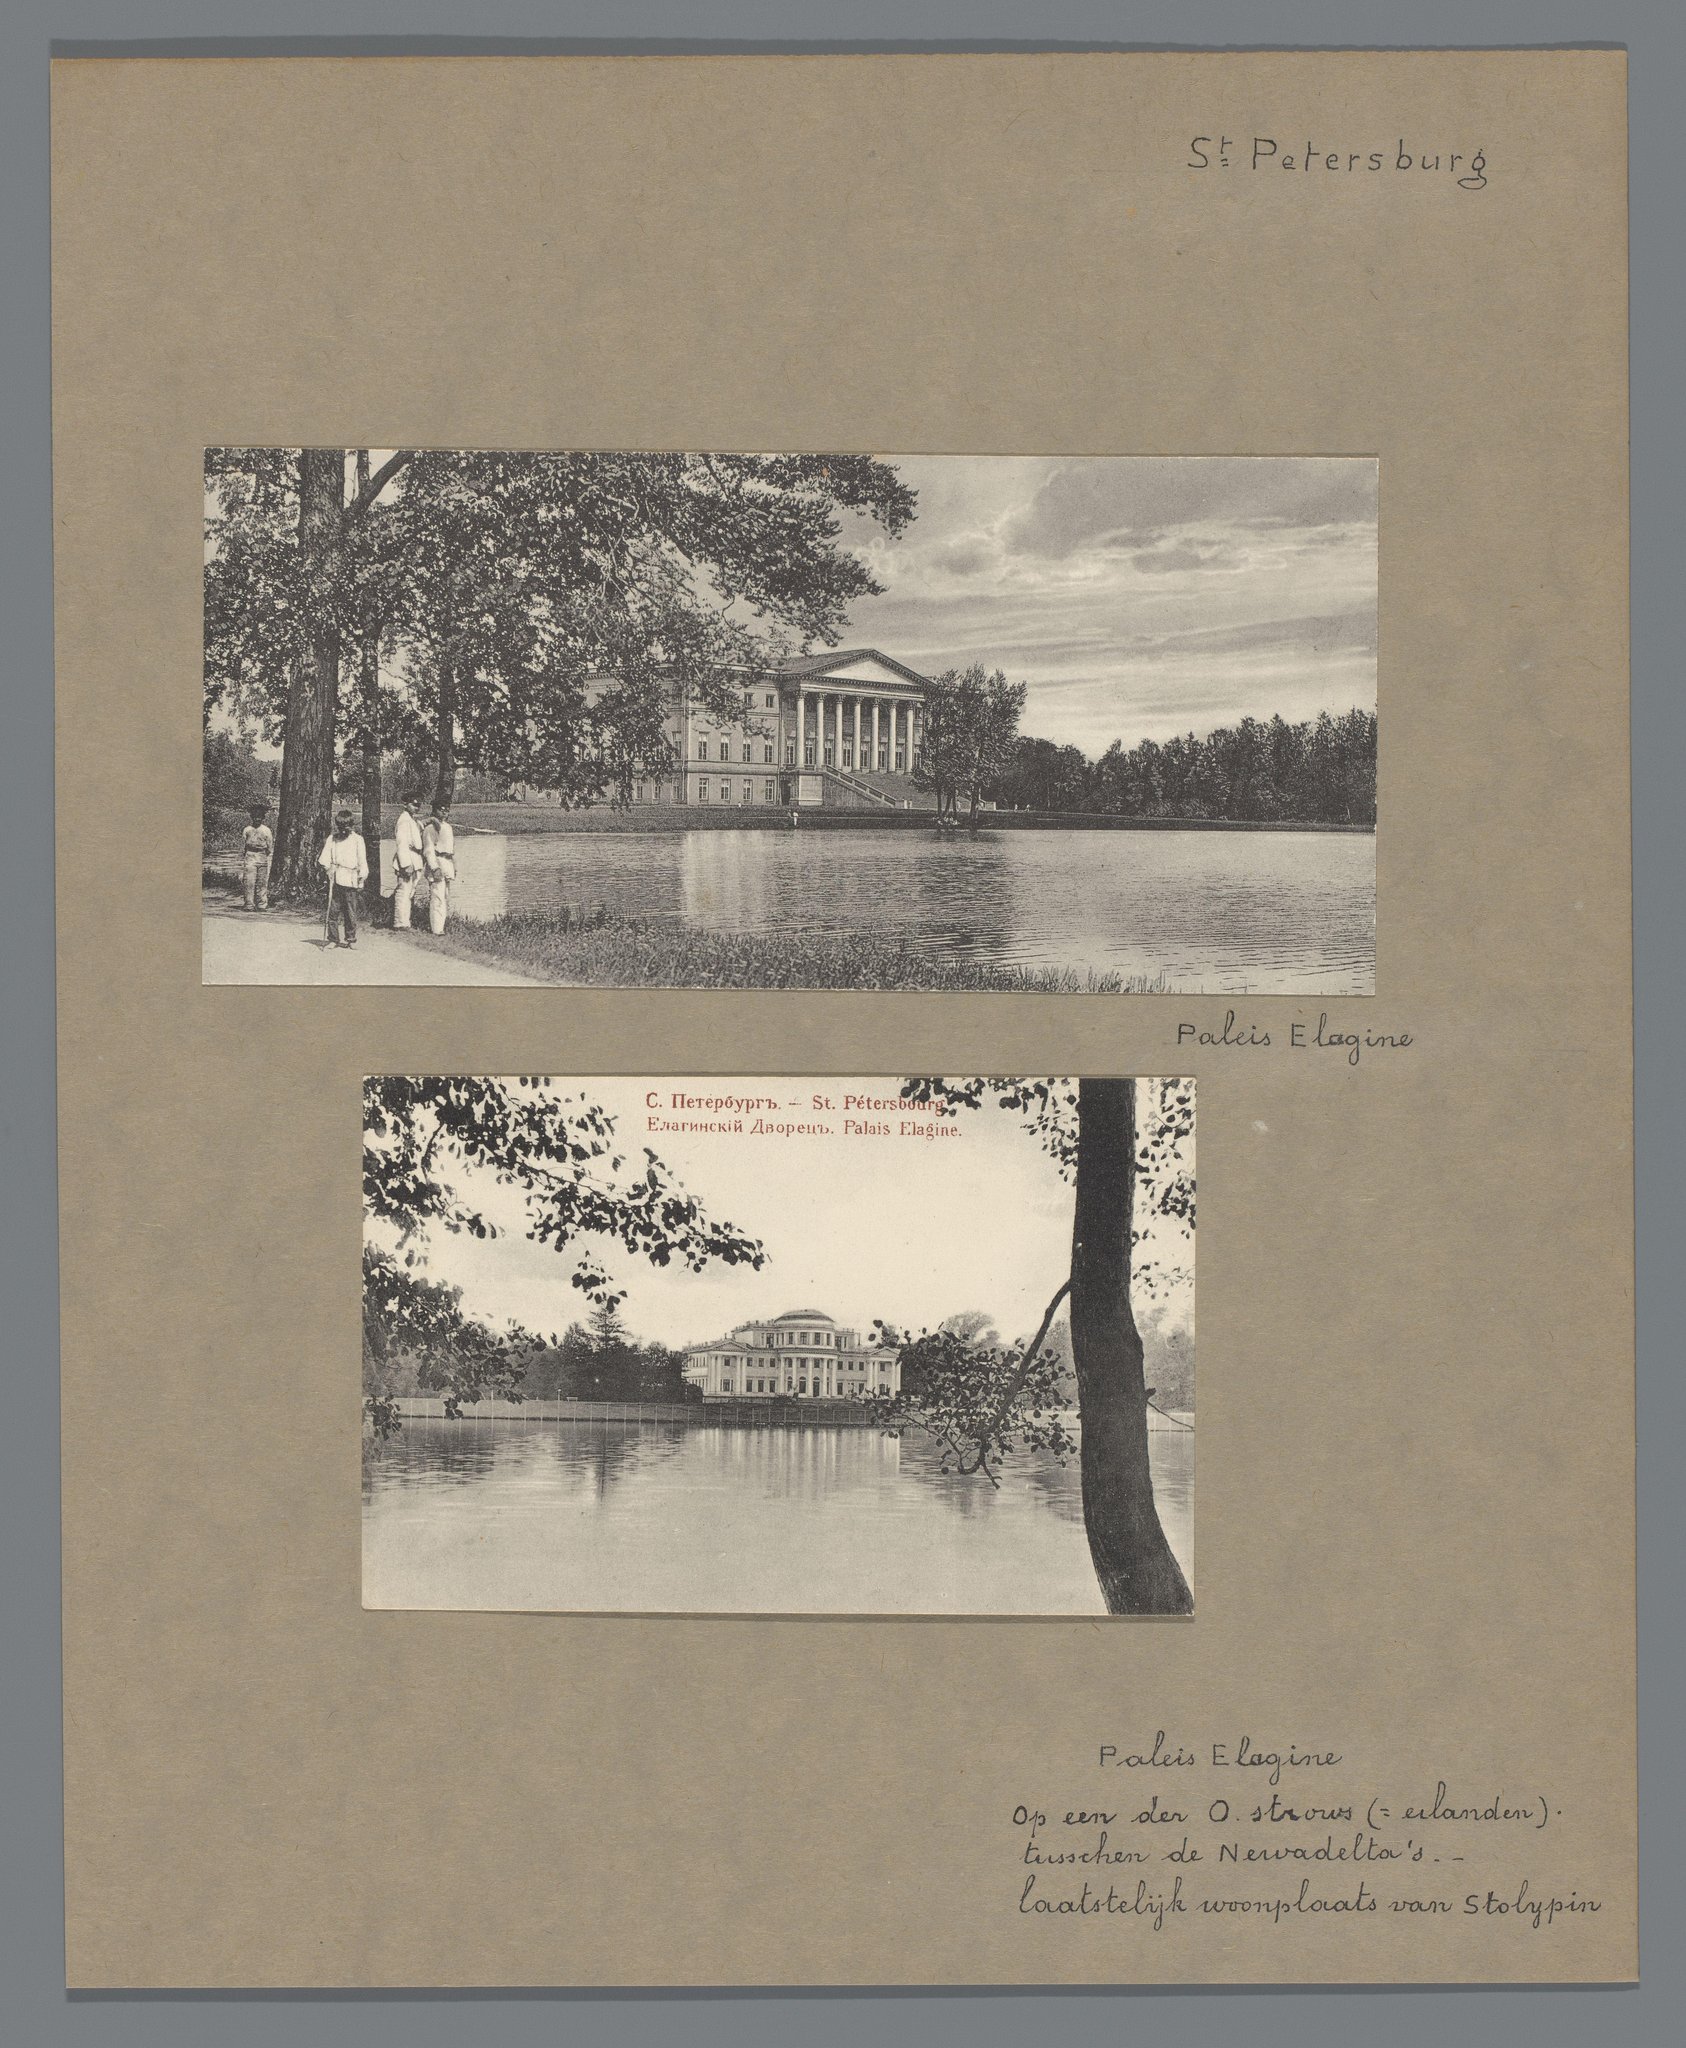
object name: photograph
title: St. Petersburg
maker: Anonymous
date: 1860-1925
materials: photographic support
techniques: photograph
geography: russia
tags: sint-petersburg